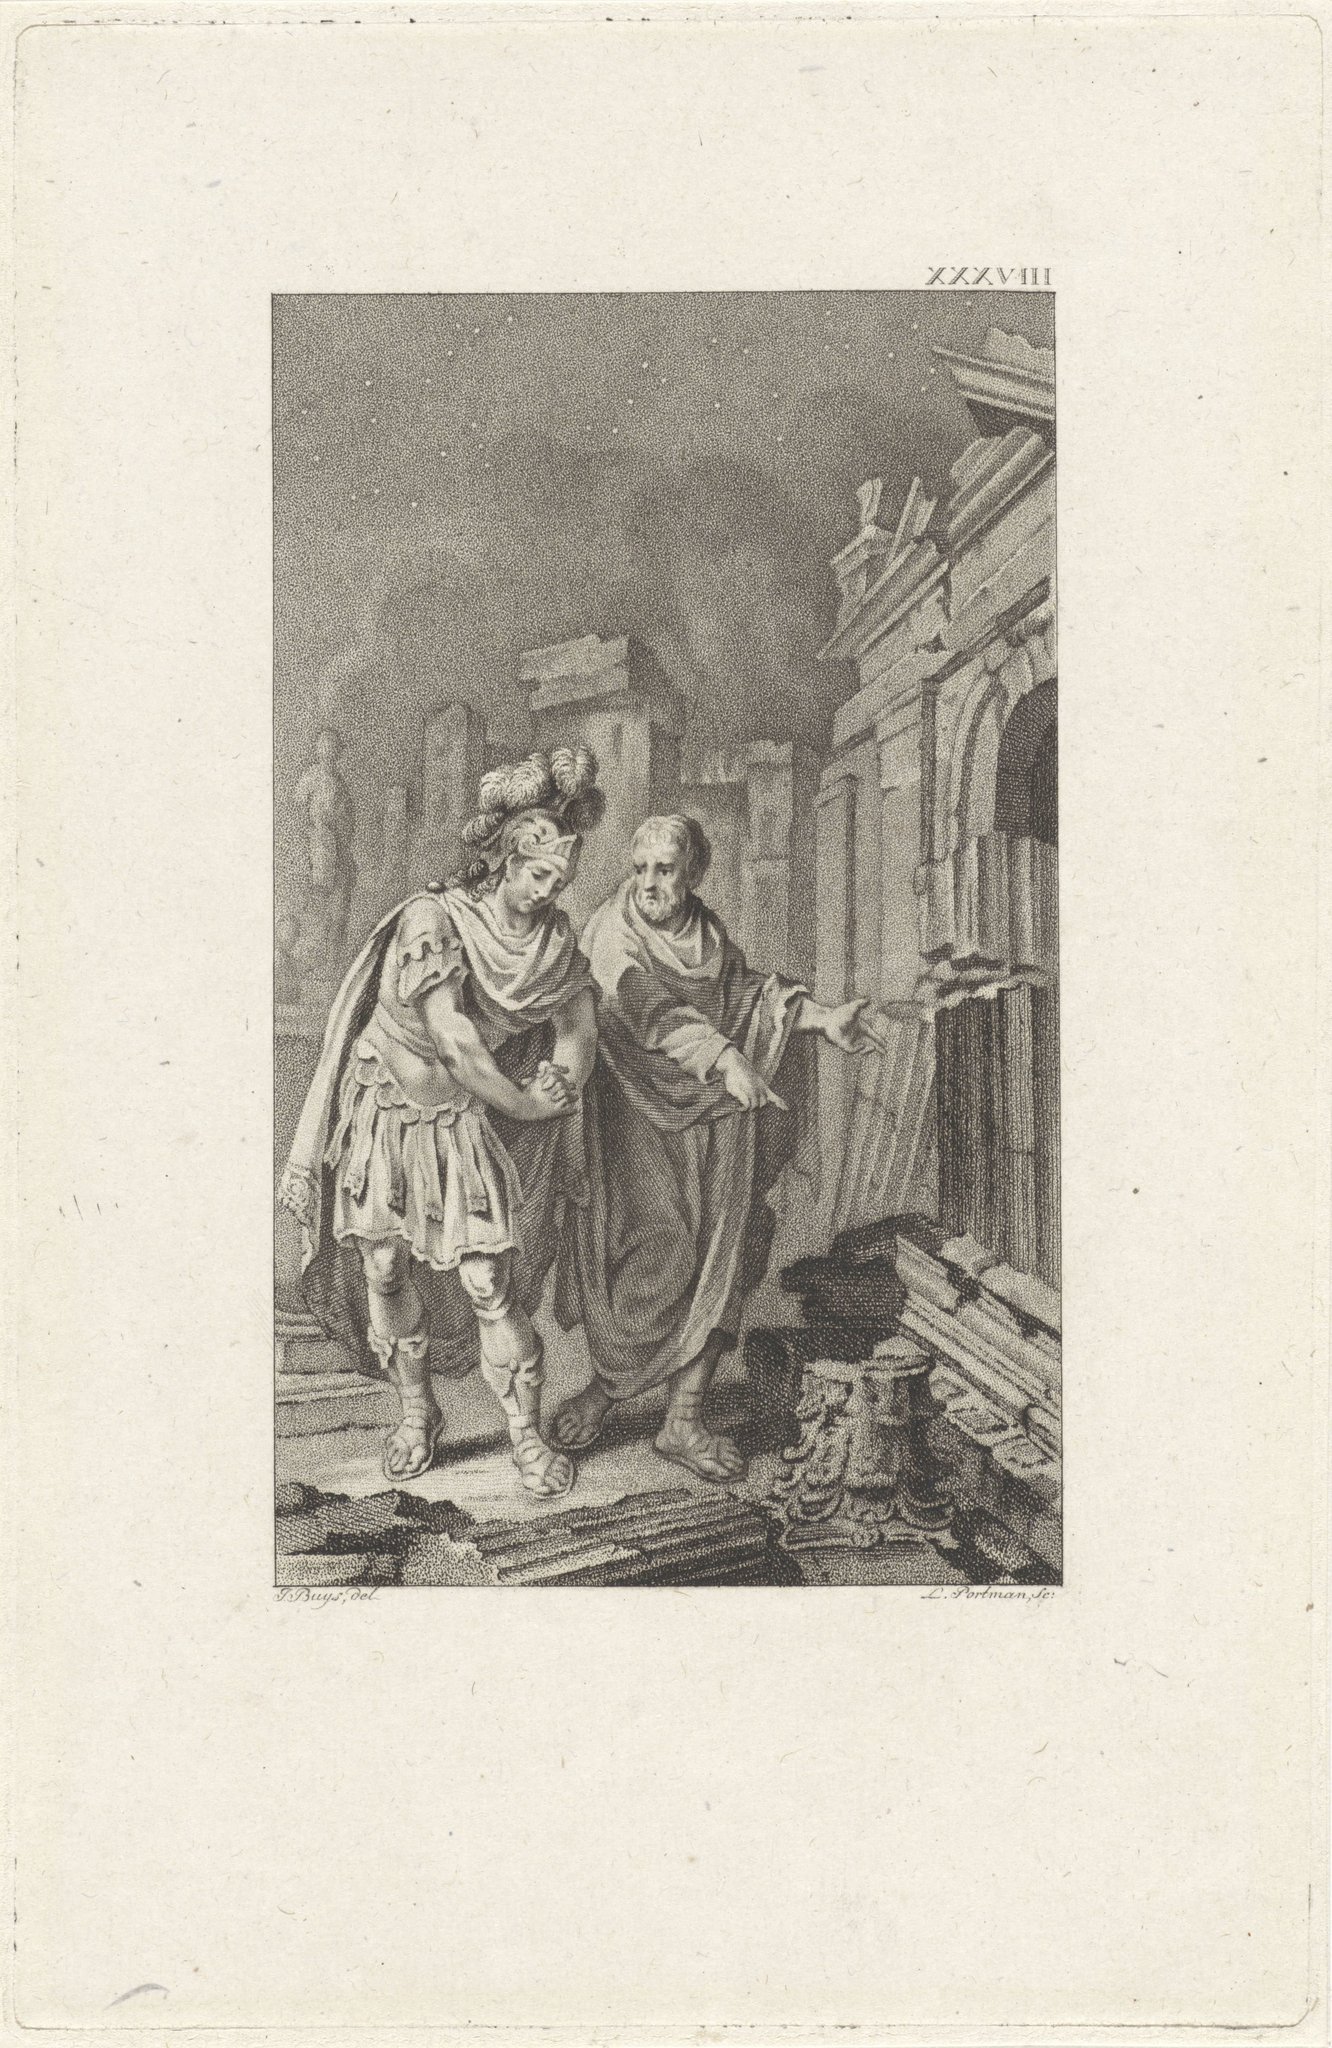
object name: book illustration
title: Scipio beweent Carthago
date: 1797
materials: paper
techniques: etching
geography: amsterdam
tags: male persons from classical history (scipio aemilianus)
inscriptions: collector's mark: Lugt 2228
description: In de nacht staat Scipio tussen de puinhopen van de verwoeste stad Carthago. Hij wordt vergezeld door zijn vriend Polybius.